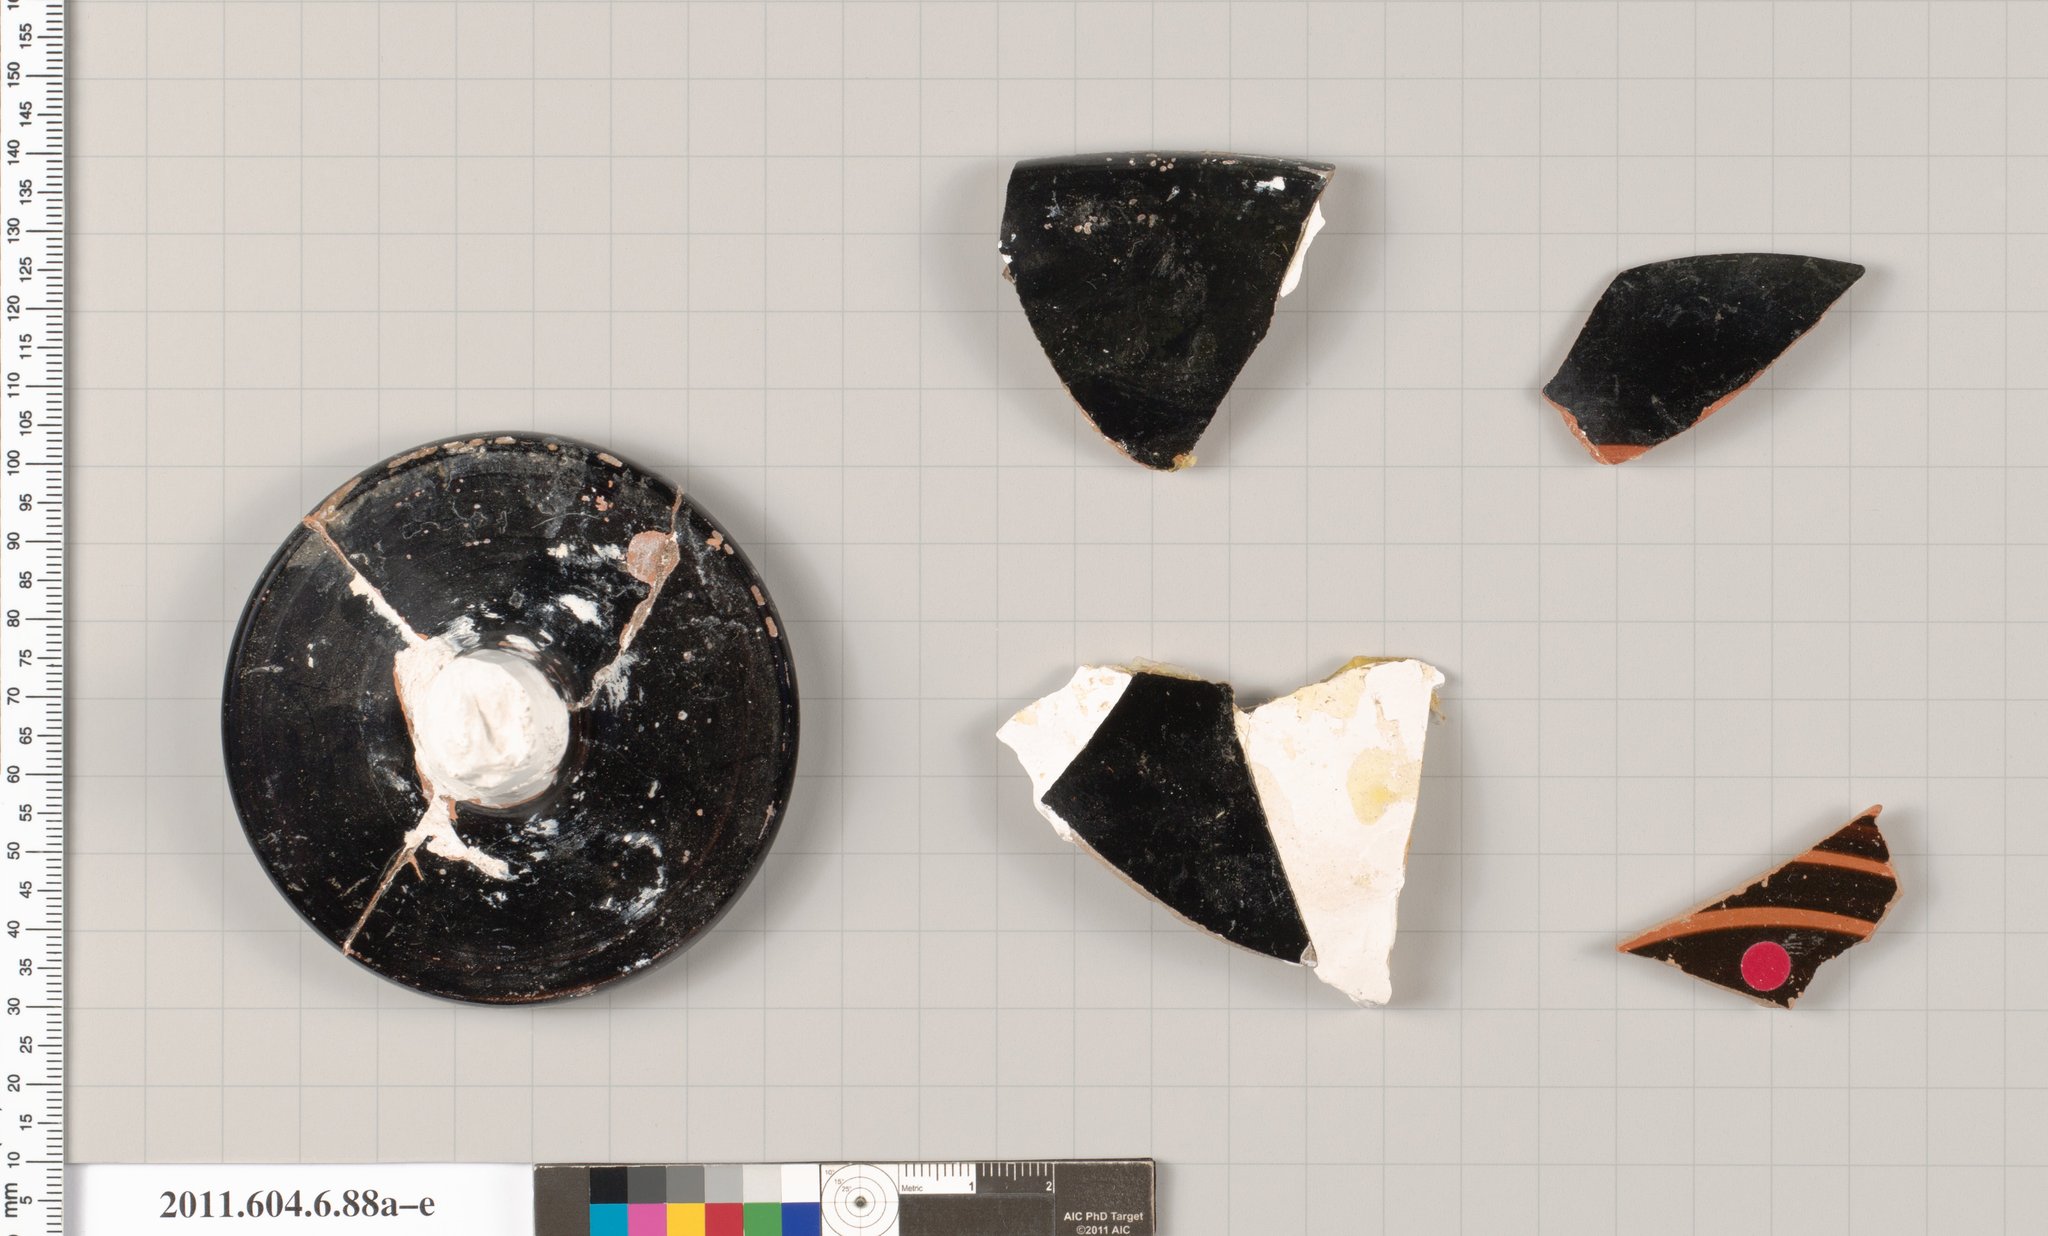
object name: plate fragment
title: Terracotta fragments of a stemmed plate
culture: greek, attic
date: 500-401 BCE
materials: terracotta